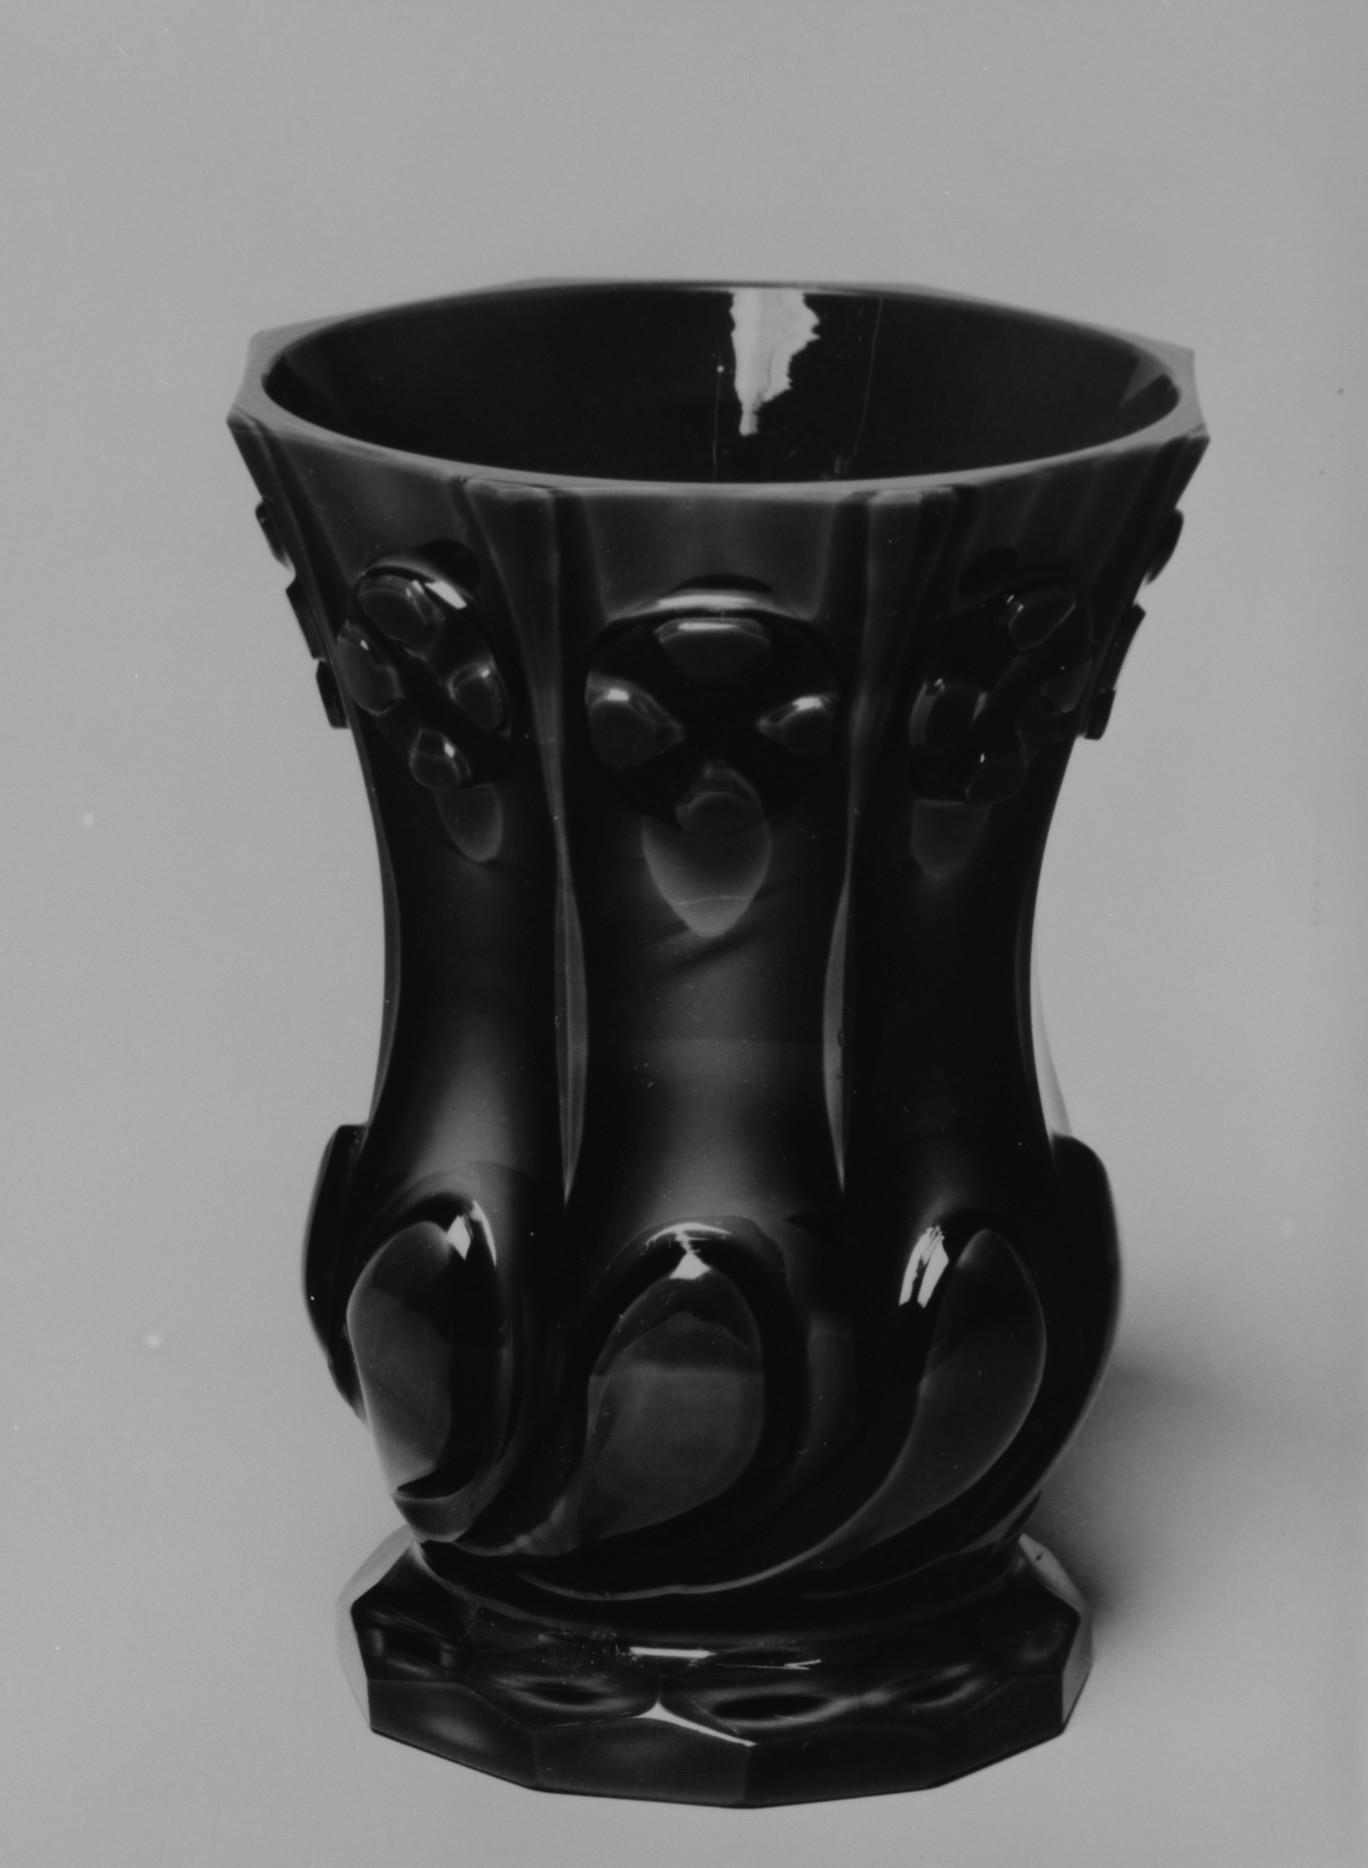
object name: beaker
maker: joseph wenzel zick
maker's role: maker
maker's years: 1820-1840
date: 1830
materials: glass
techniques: cutting, polish